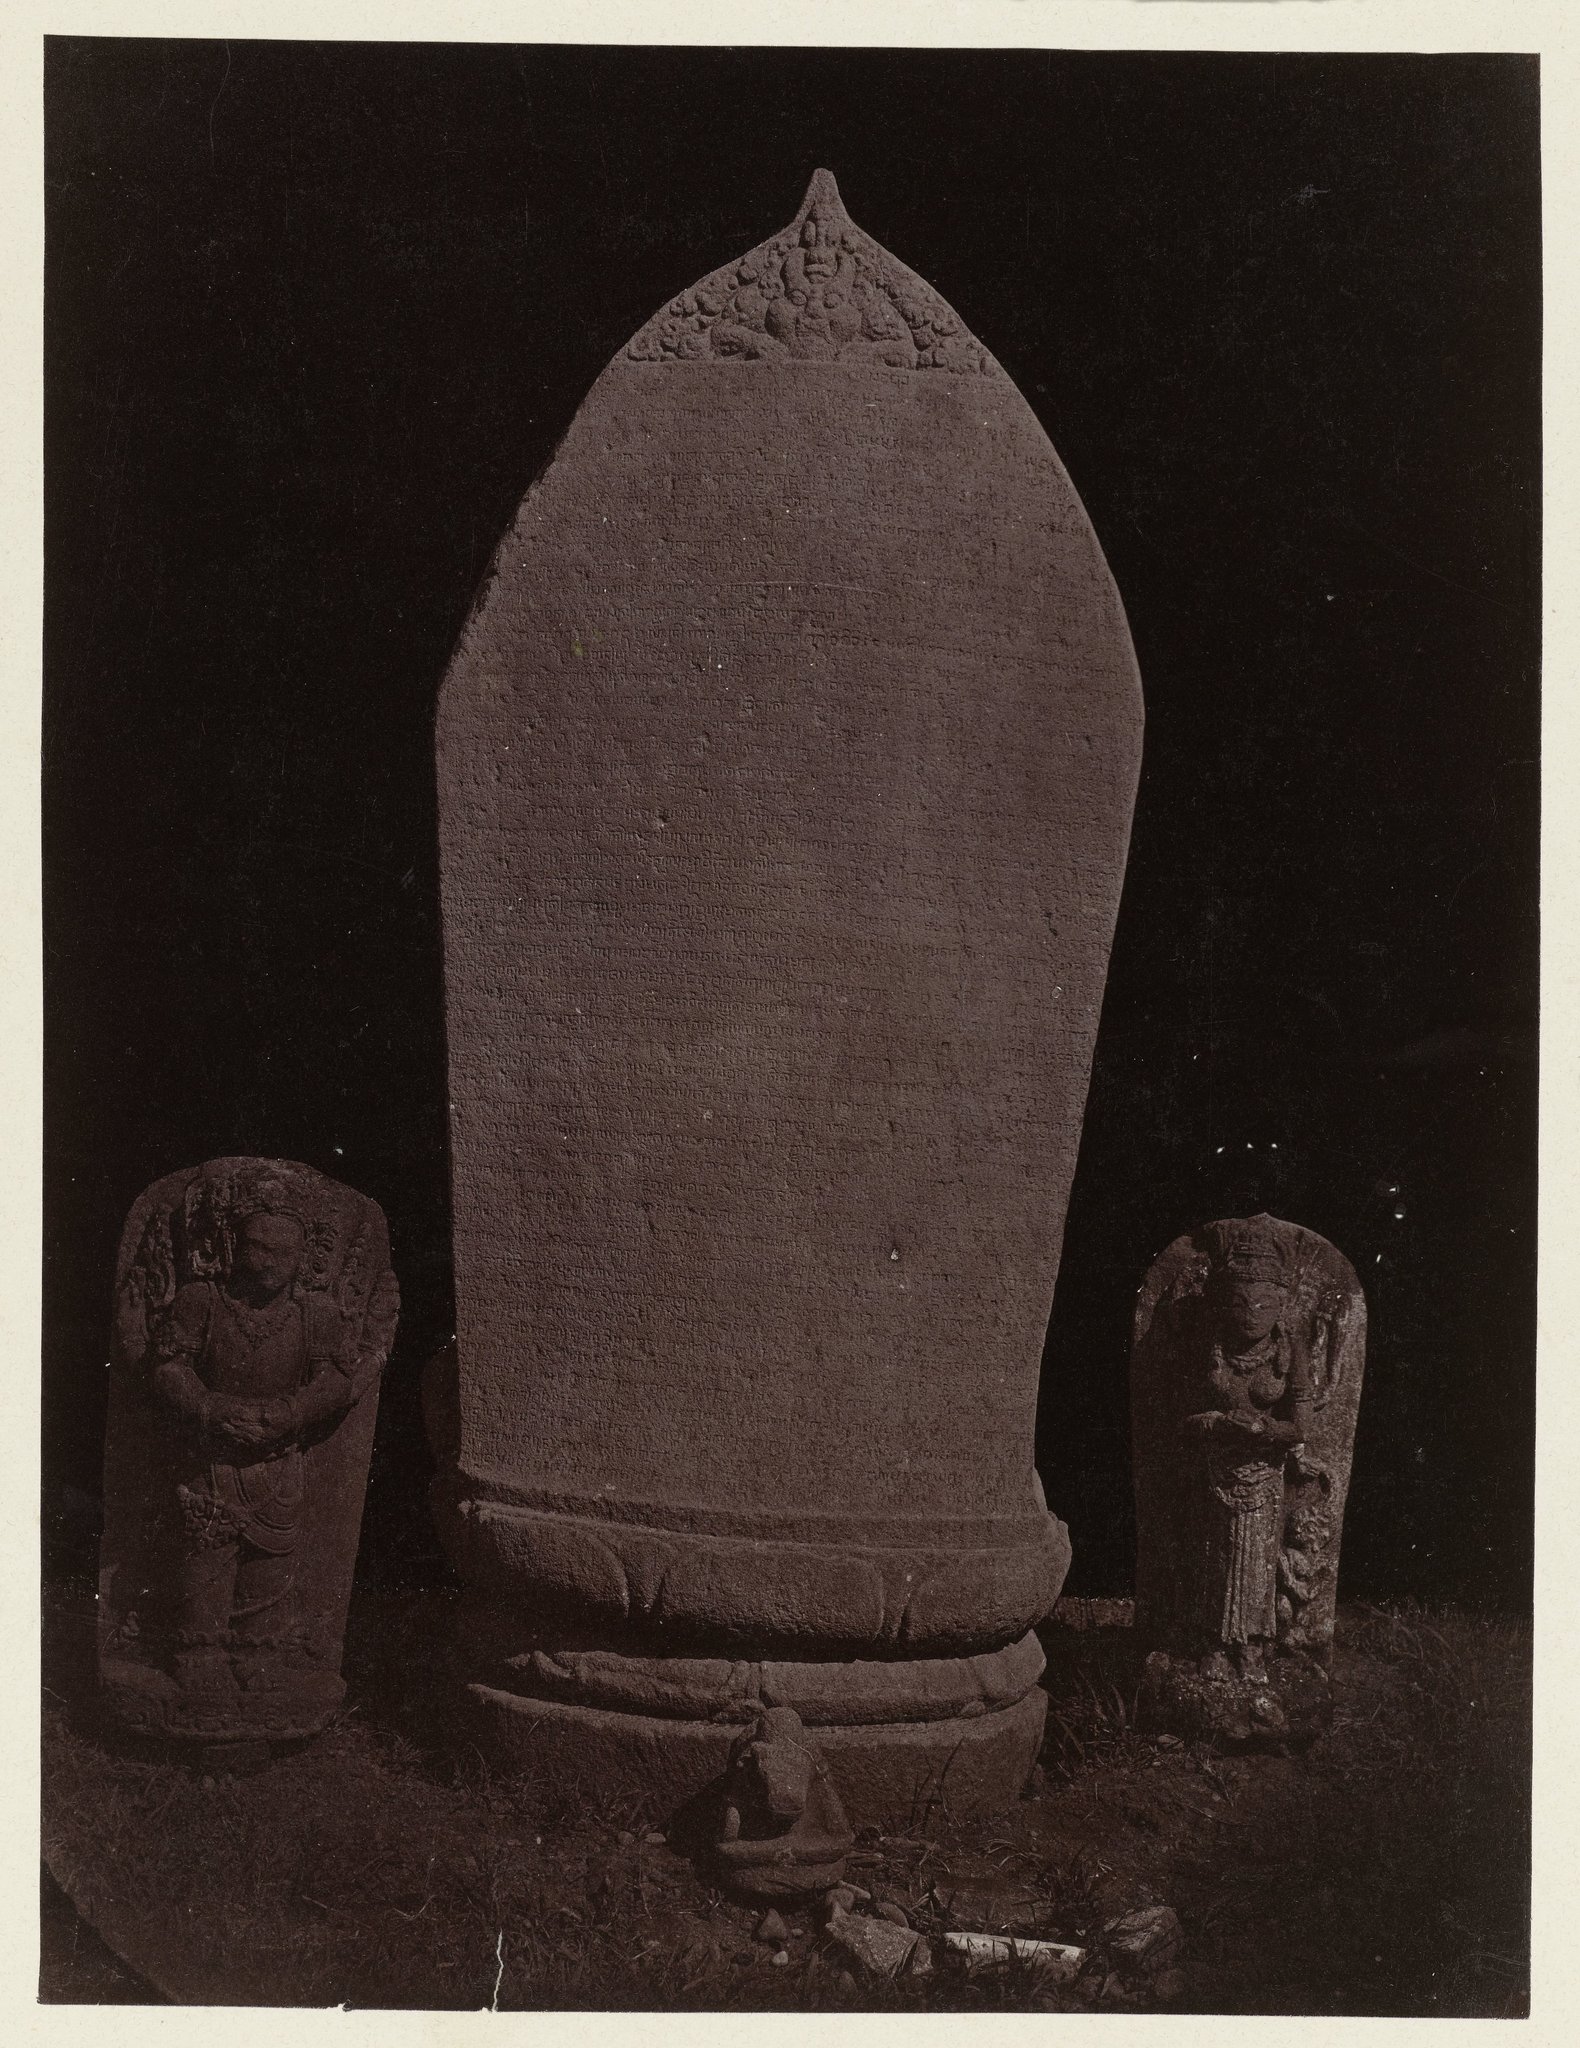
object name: photograph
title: Inscribes slab (Old Javanese language, East Javanese Kawi script) from Candi Lor with a kalamukha on top (rear view); three statuettes (Surya, Nandi, femal dification imade), Residential house. Kediri, Kediri district, East Java province, 900-910 AD.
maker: isidore kinsbergen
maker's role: fotograaf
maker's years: 1821-1905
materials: cardboard, paper, photographic support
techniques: albumen print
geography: java